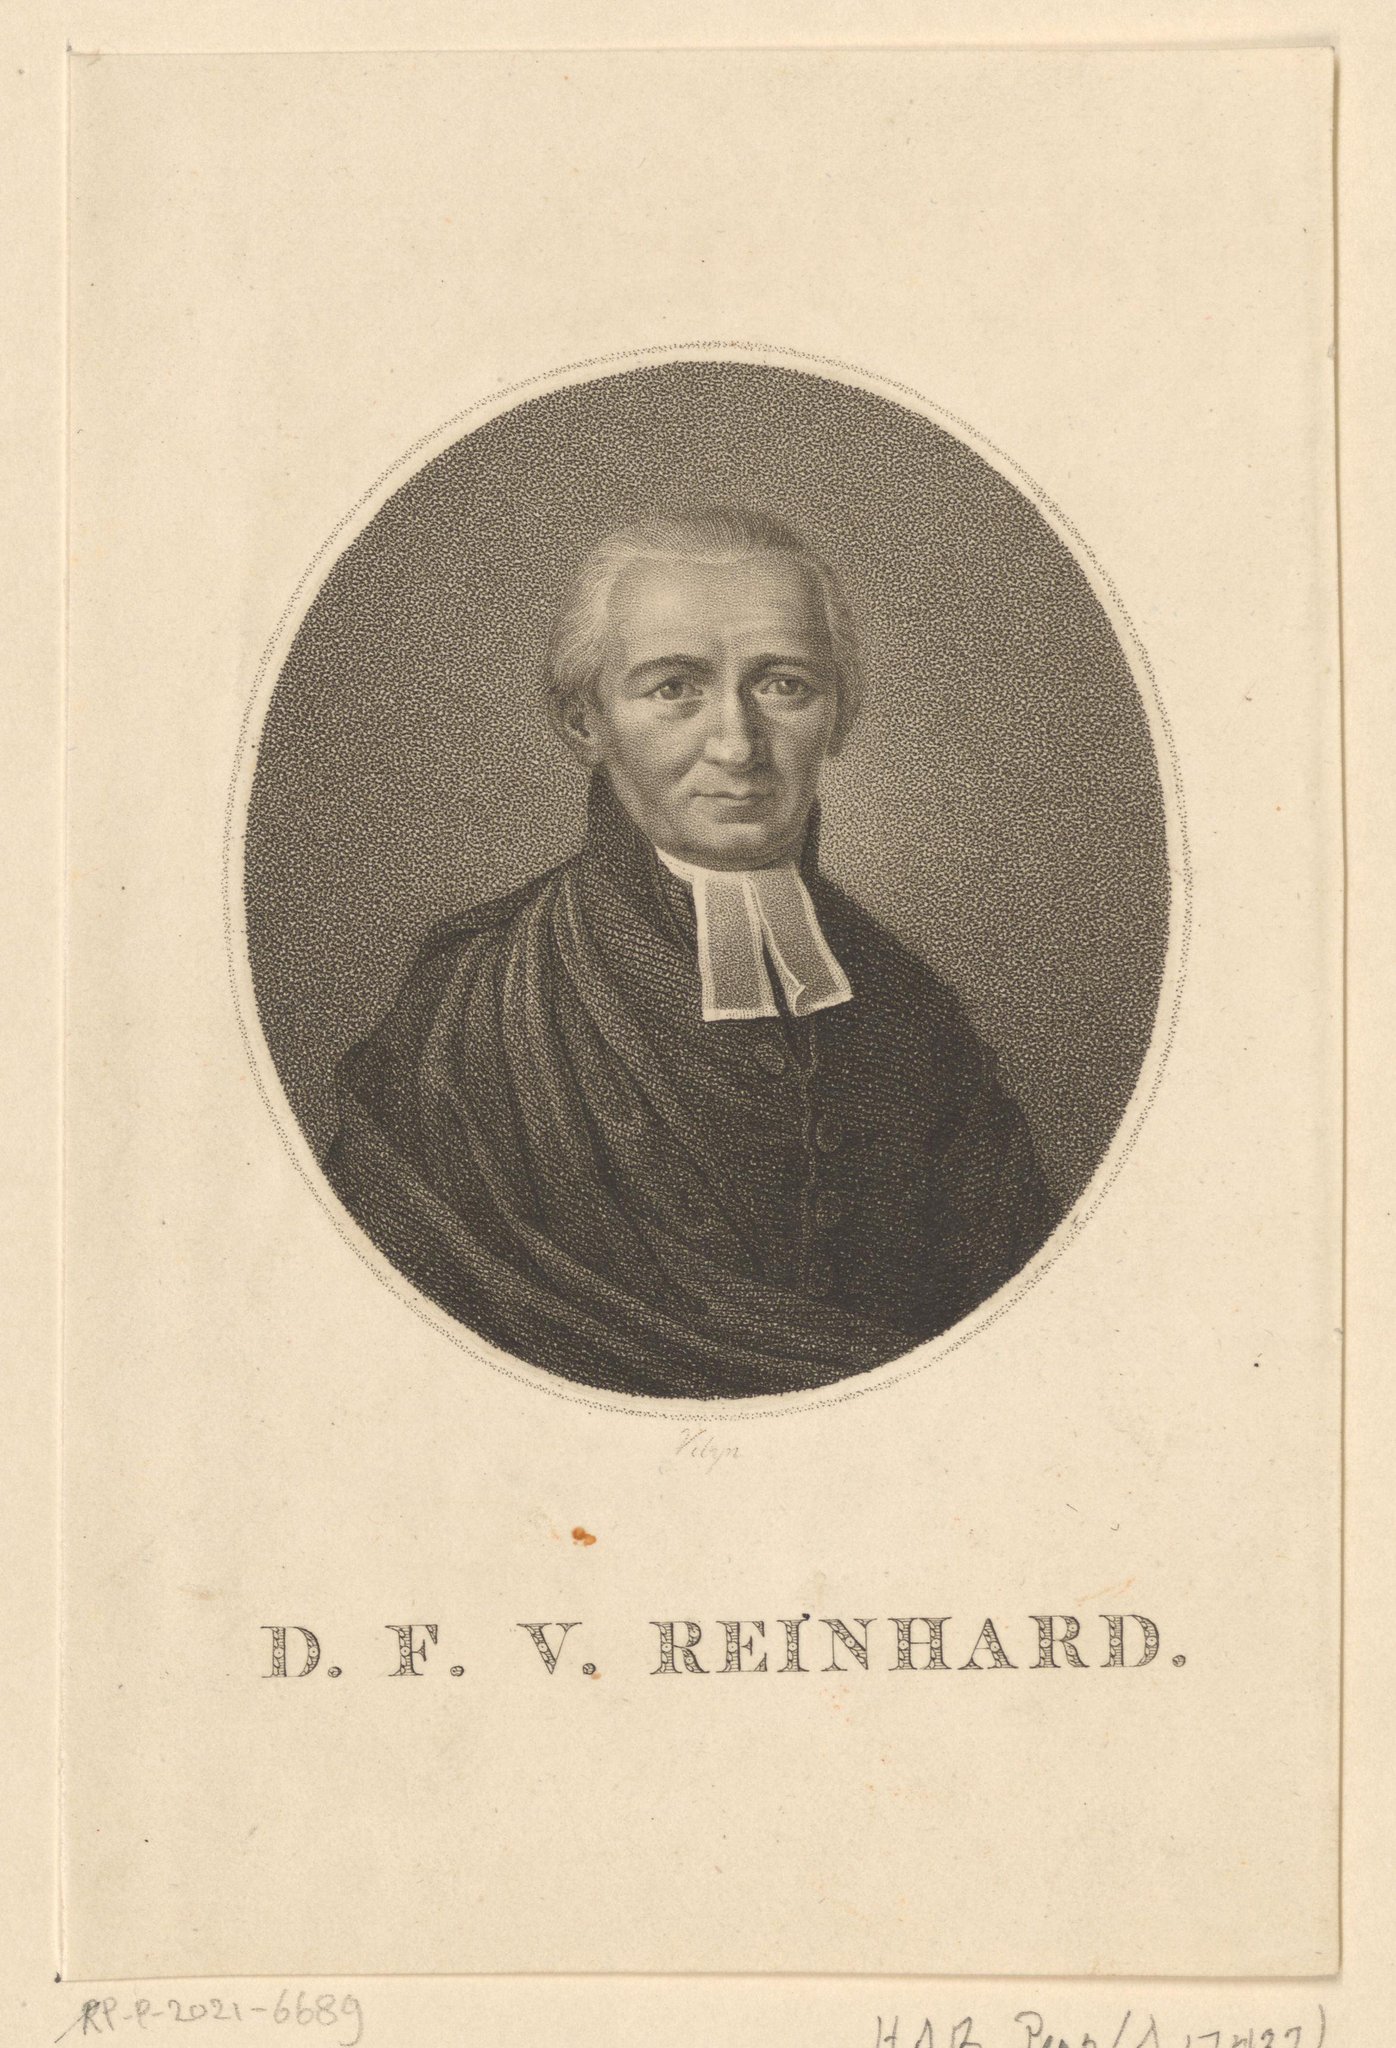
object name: print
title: Portret van Franz Volkmar Reinhard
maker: philippus velijn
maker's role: print maker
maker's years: 1787-1836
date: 1812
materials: paper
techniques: stippling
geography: leiden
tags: historical persons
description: Prent mogelijk uit: Reinhard, Franz Volkmar. De christelijke zede-leer (...). Leiden: Abraham en Jan Honkoop, 1812, dl. 7.